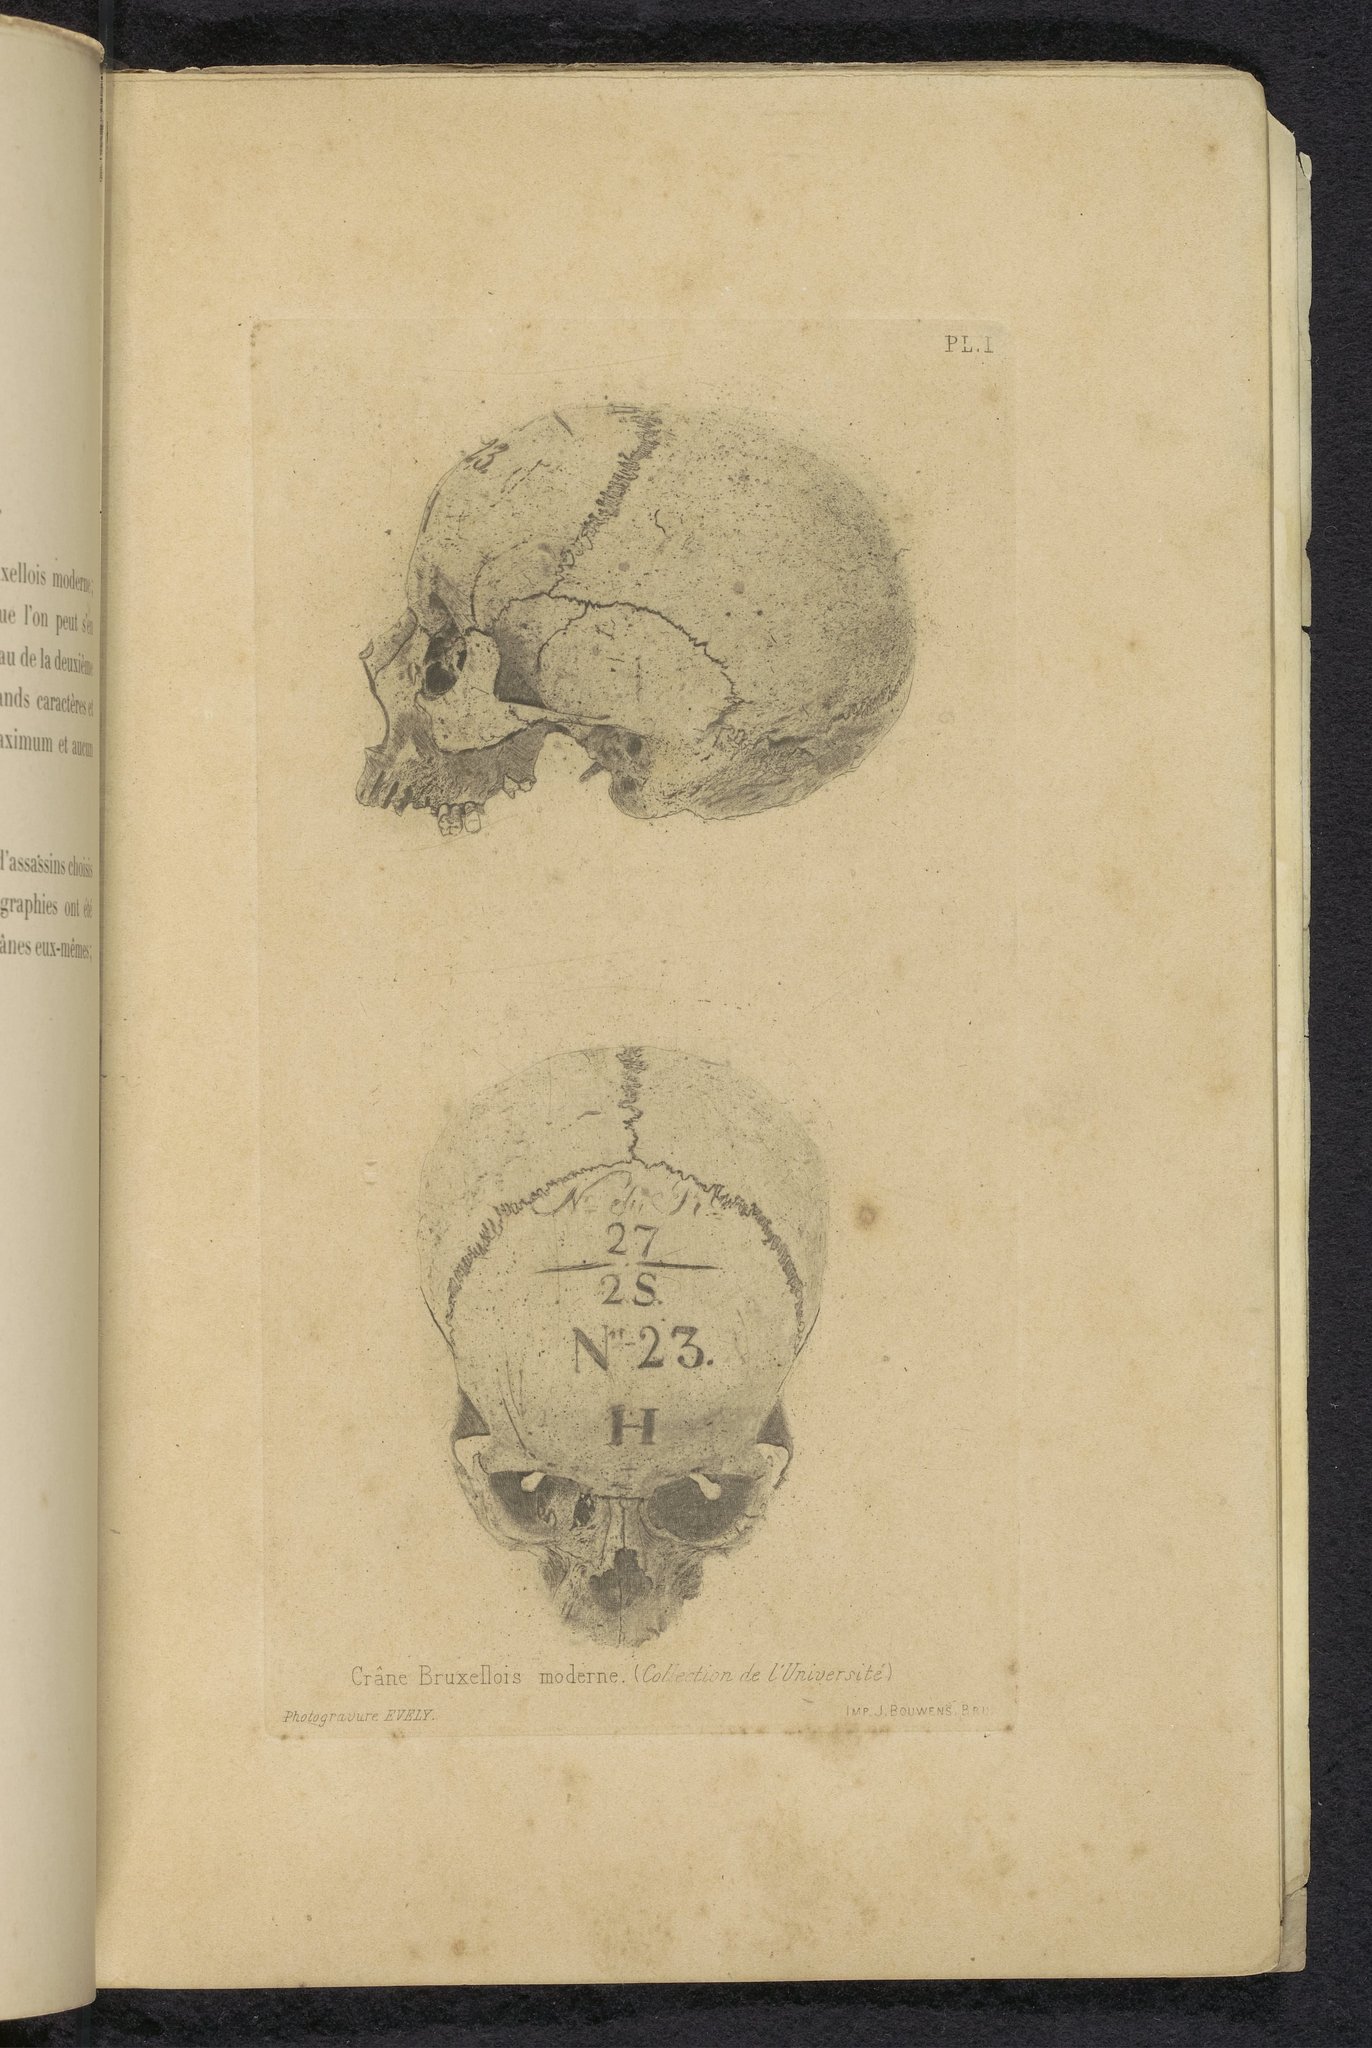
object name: photomechanical print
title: Crâne Bruxellois moderne. (Collection de l'Université)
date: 1871-1881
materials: paper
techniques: photoaquatint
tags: (human) skull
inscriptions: number: ‘PL. I.’, inscription: ‘No. 27 2s No. 23. H’